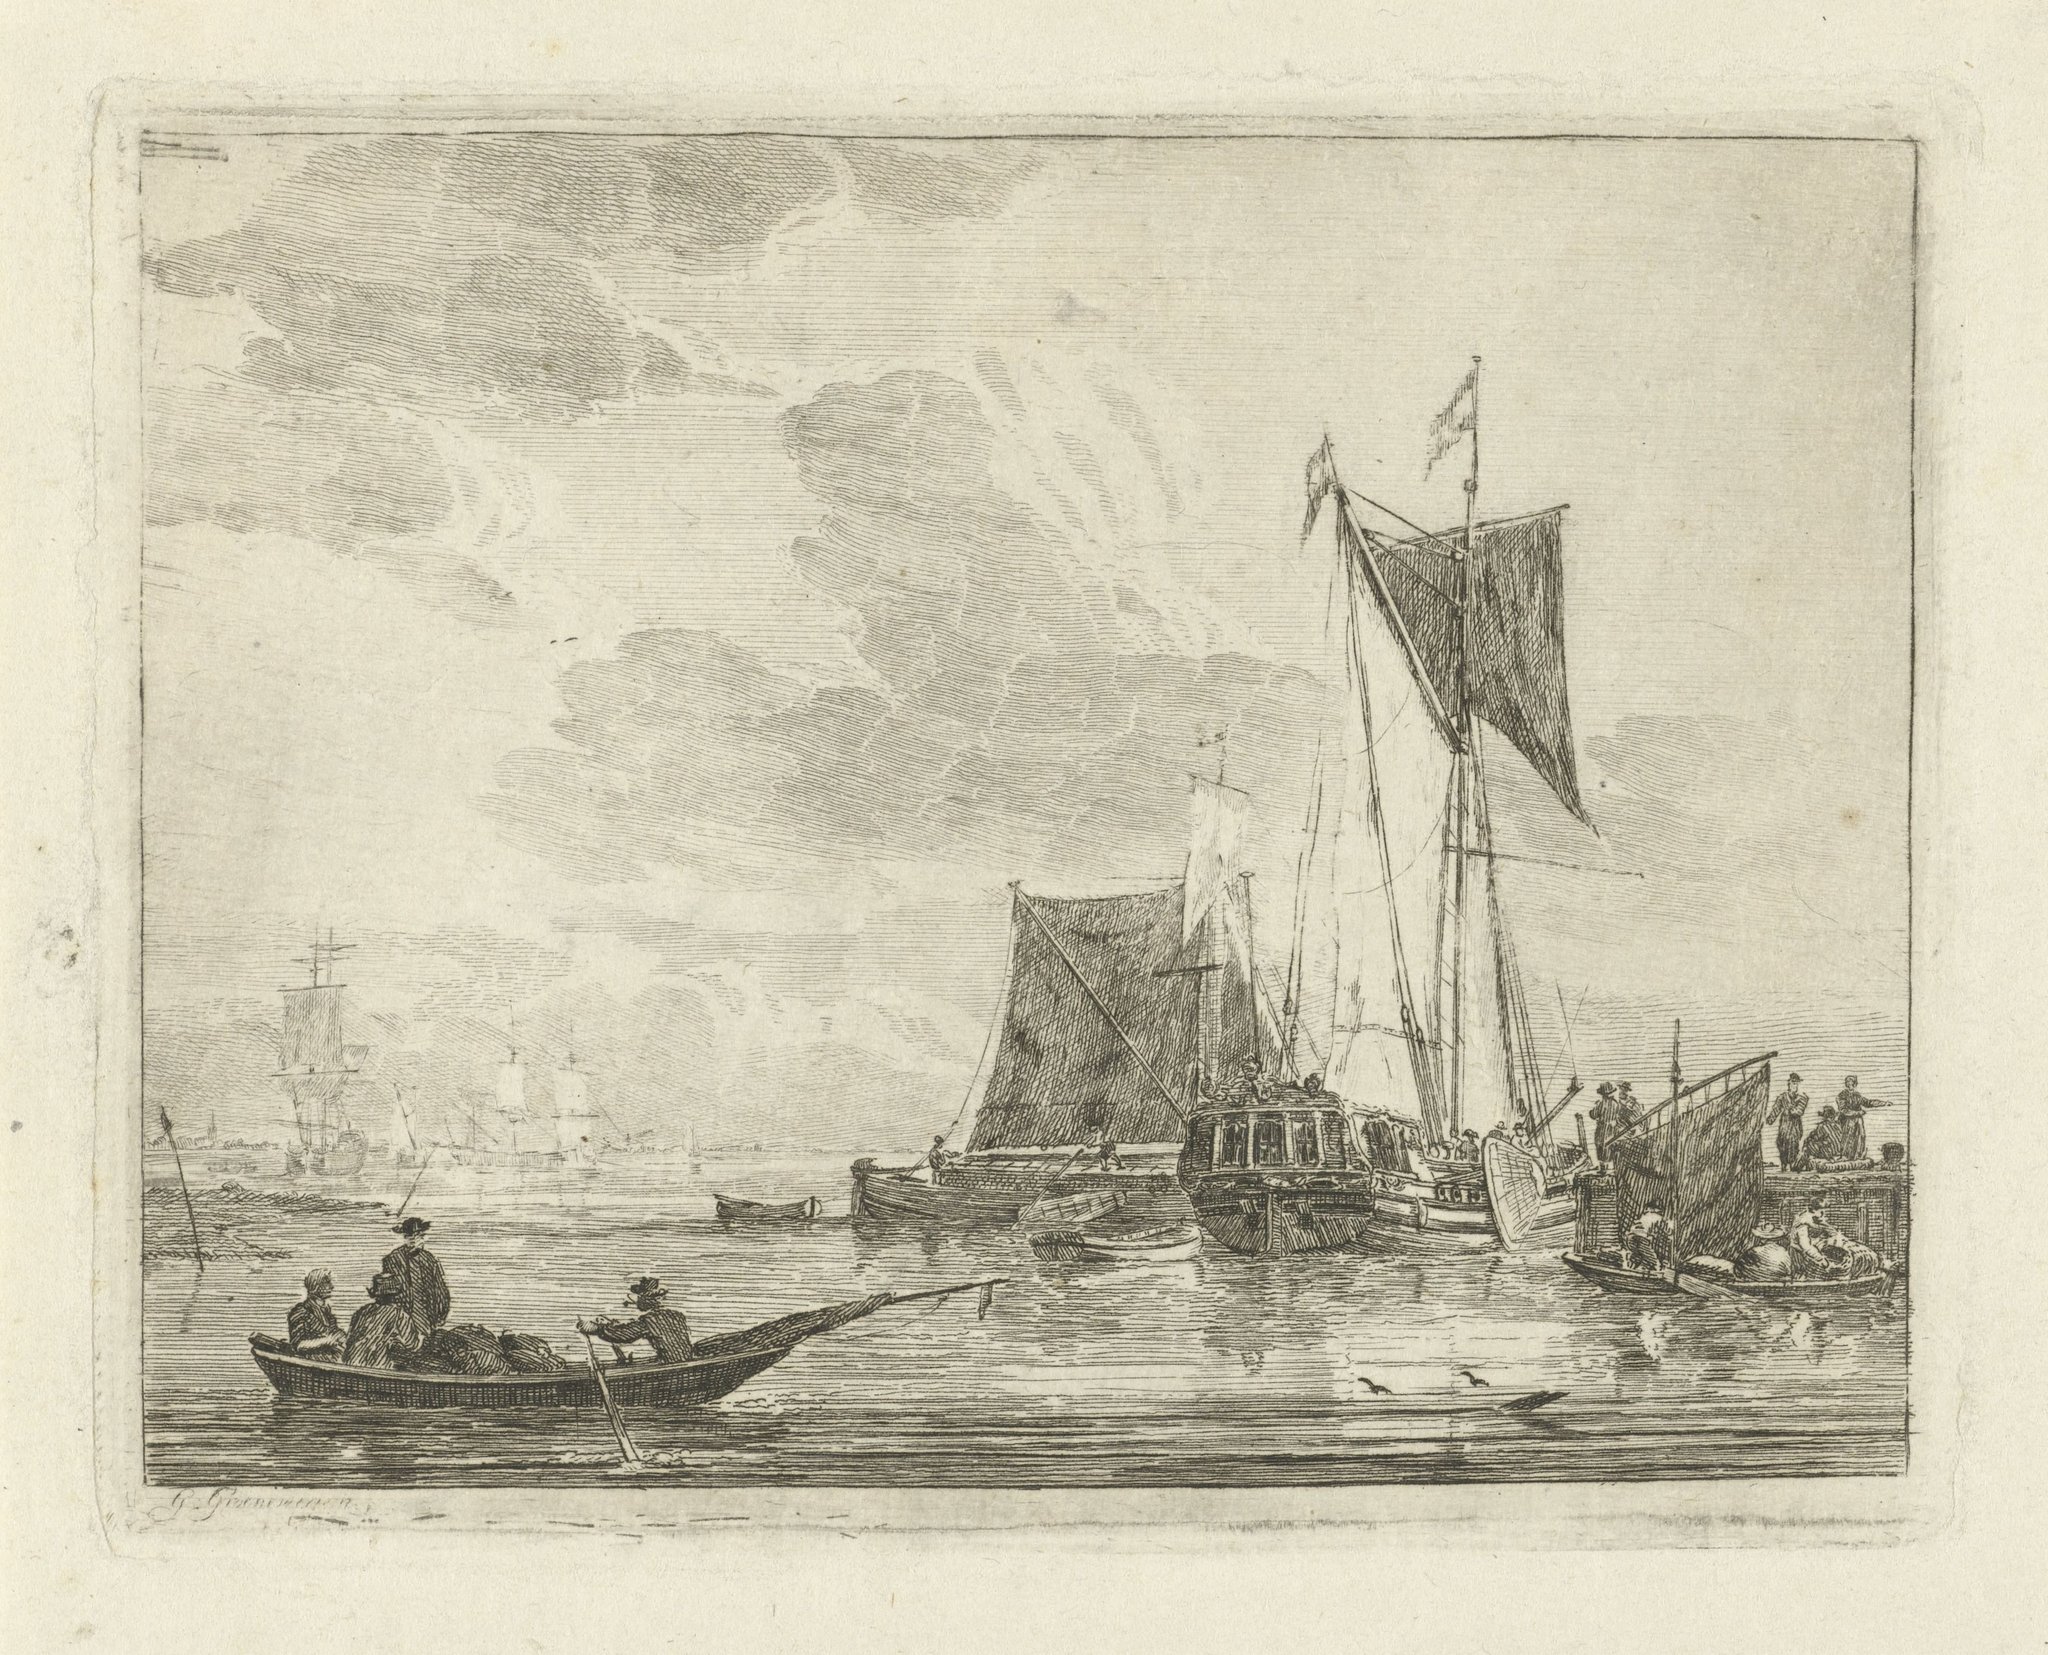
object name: print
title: Schepen bij een steiger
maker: gerrit groenewegen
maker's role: draughtsman, print maker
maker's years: 1754-1826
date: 1786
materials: paper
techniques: etching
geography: rotterdam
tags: ships (in general), rowing-boat, canoe, etc.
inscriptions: collector's mark: Lugt 2228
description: Verschillende schepen op rustig water bij een steiger. Links een roeiboot met vier figuren waarvan er een roeit. Deze prent maakt deel uit van een serie van zes prenten met verschillende zeilschepen op zee.